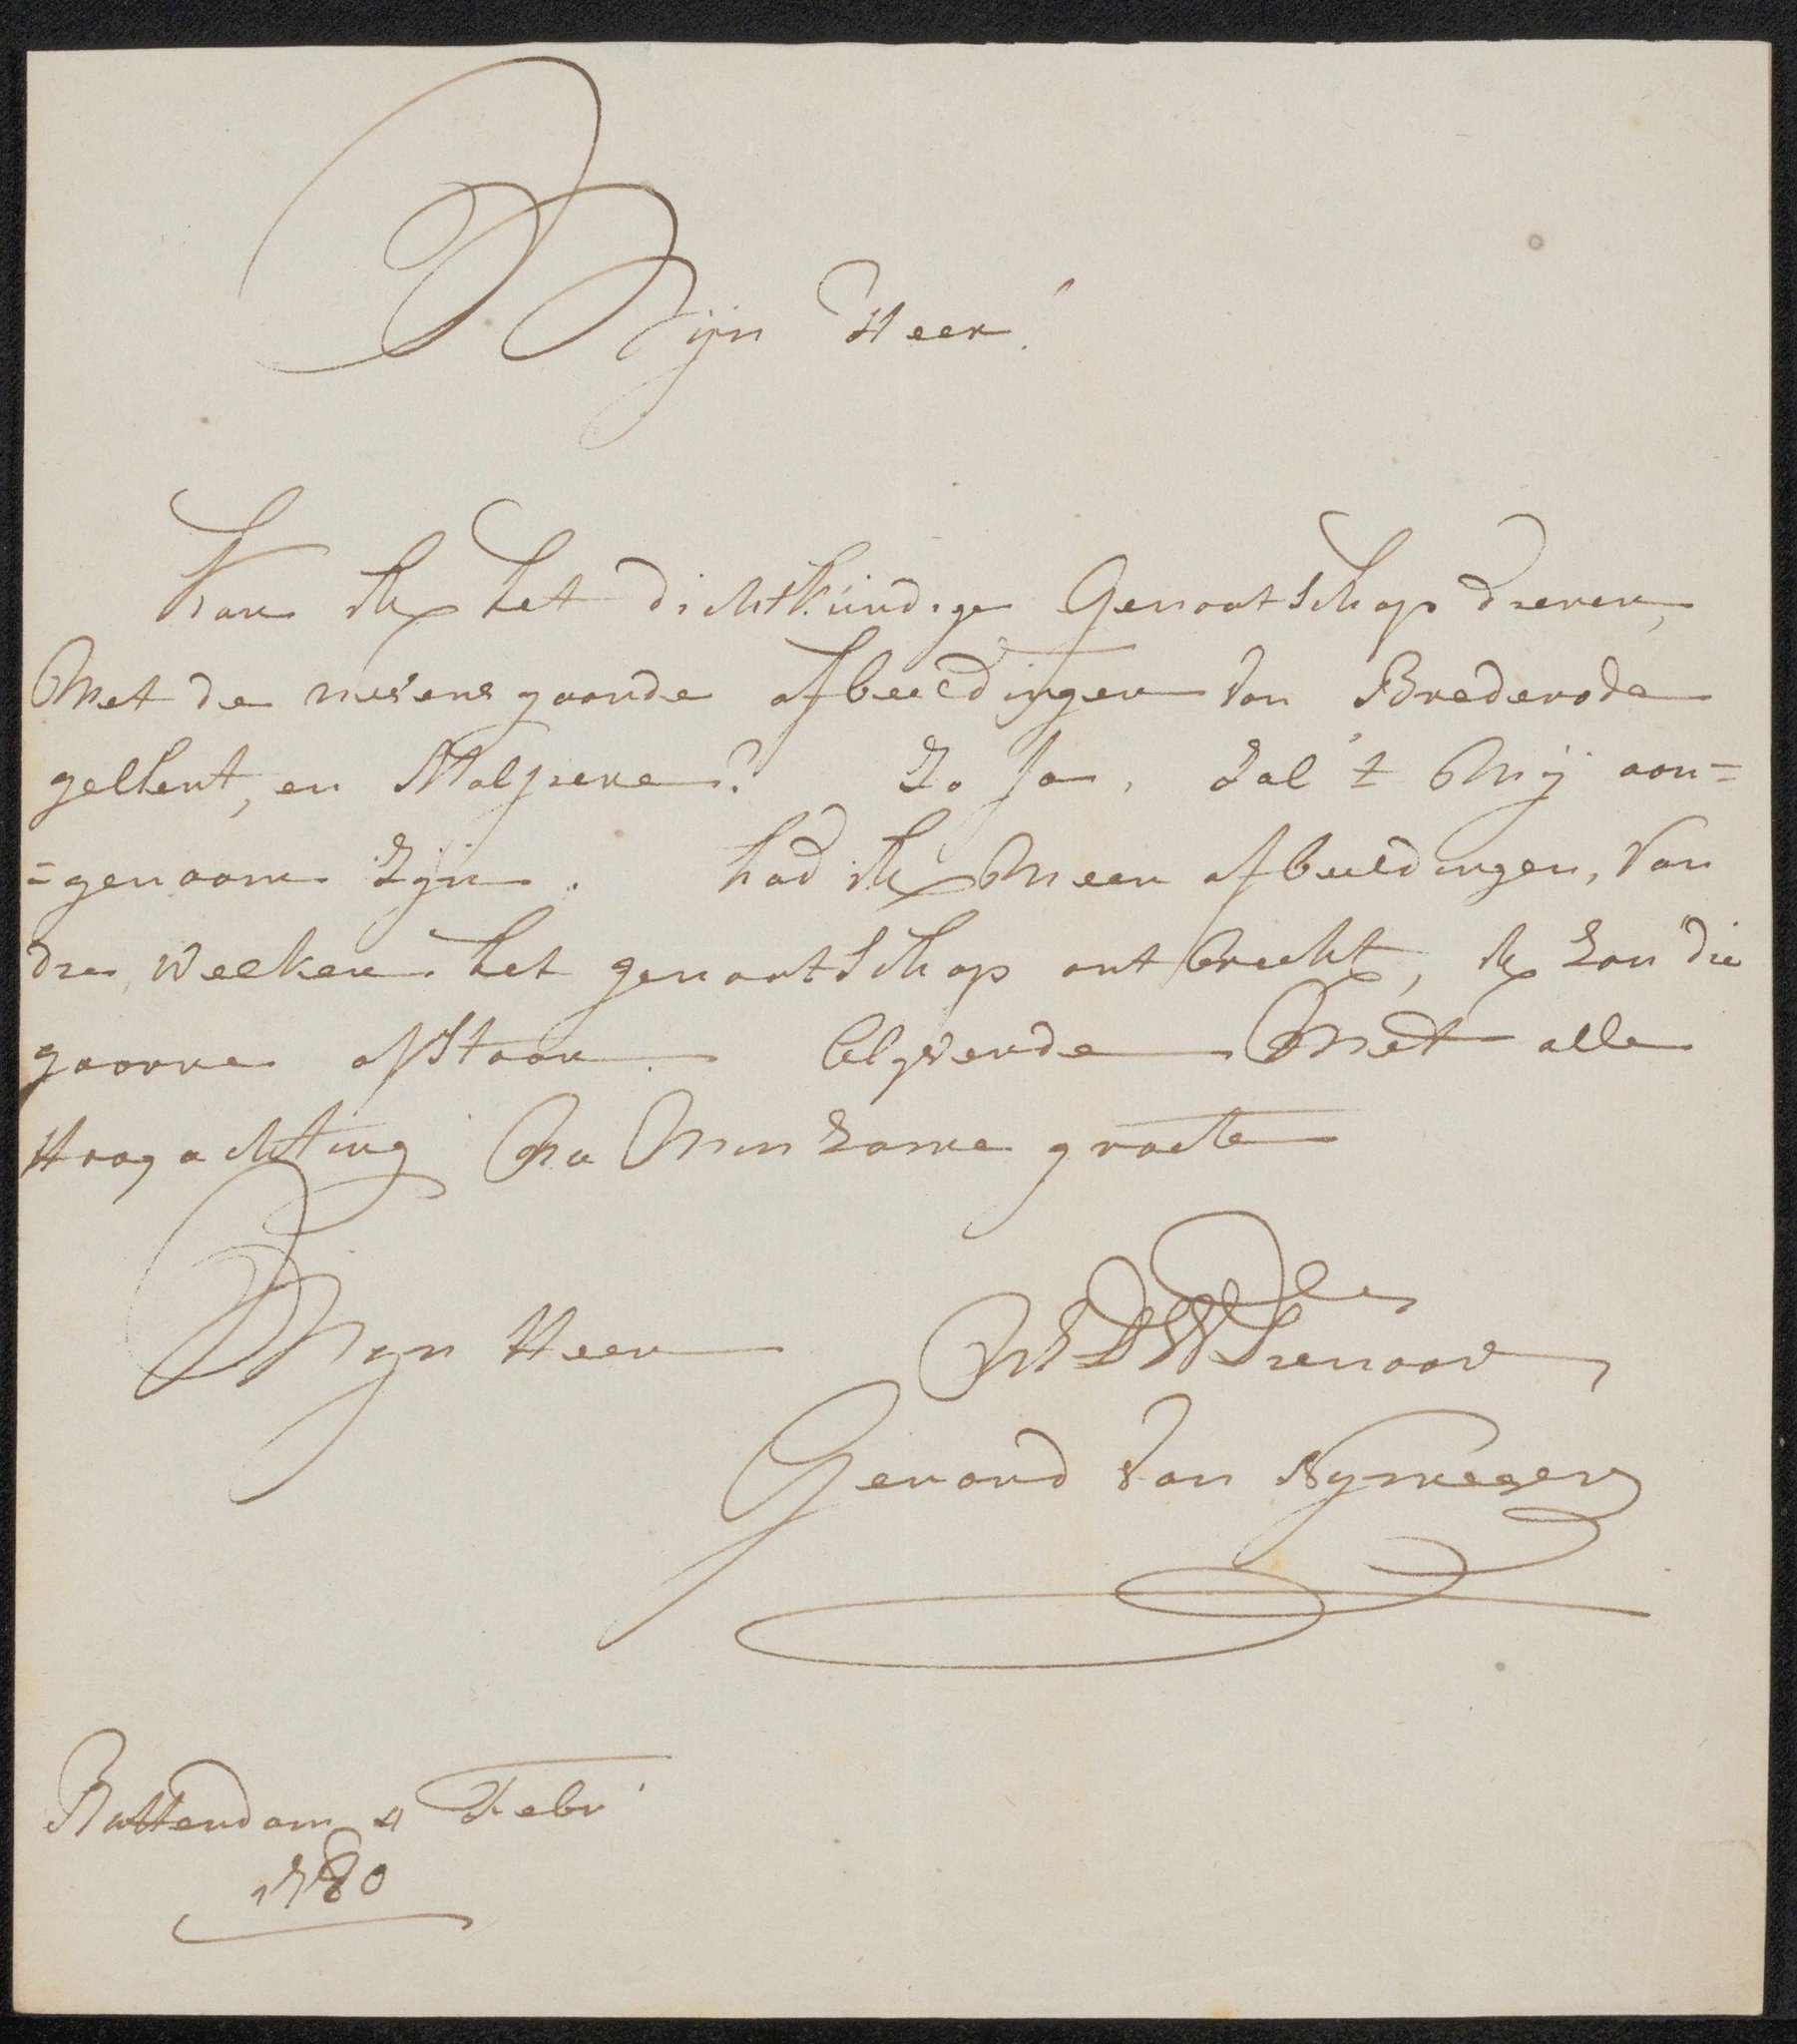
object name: letter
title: Brief aan anoniem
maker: gerard van nijmegen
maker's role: draughtsman, painter, print maker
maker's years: 1735-1808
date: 1780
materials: ink, paper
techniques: pen, writing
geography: rotterdam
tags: literature ~ arts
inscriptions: watermark